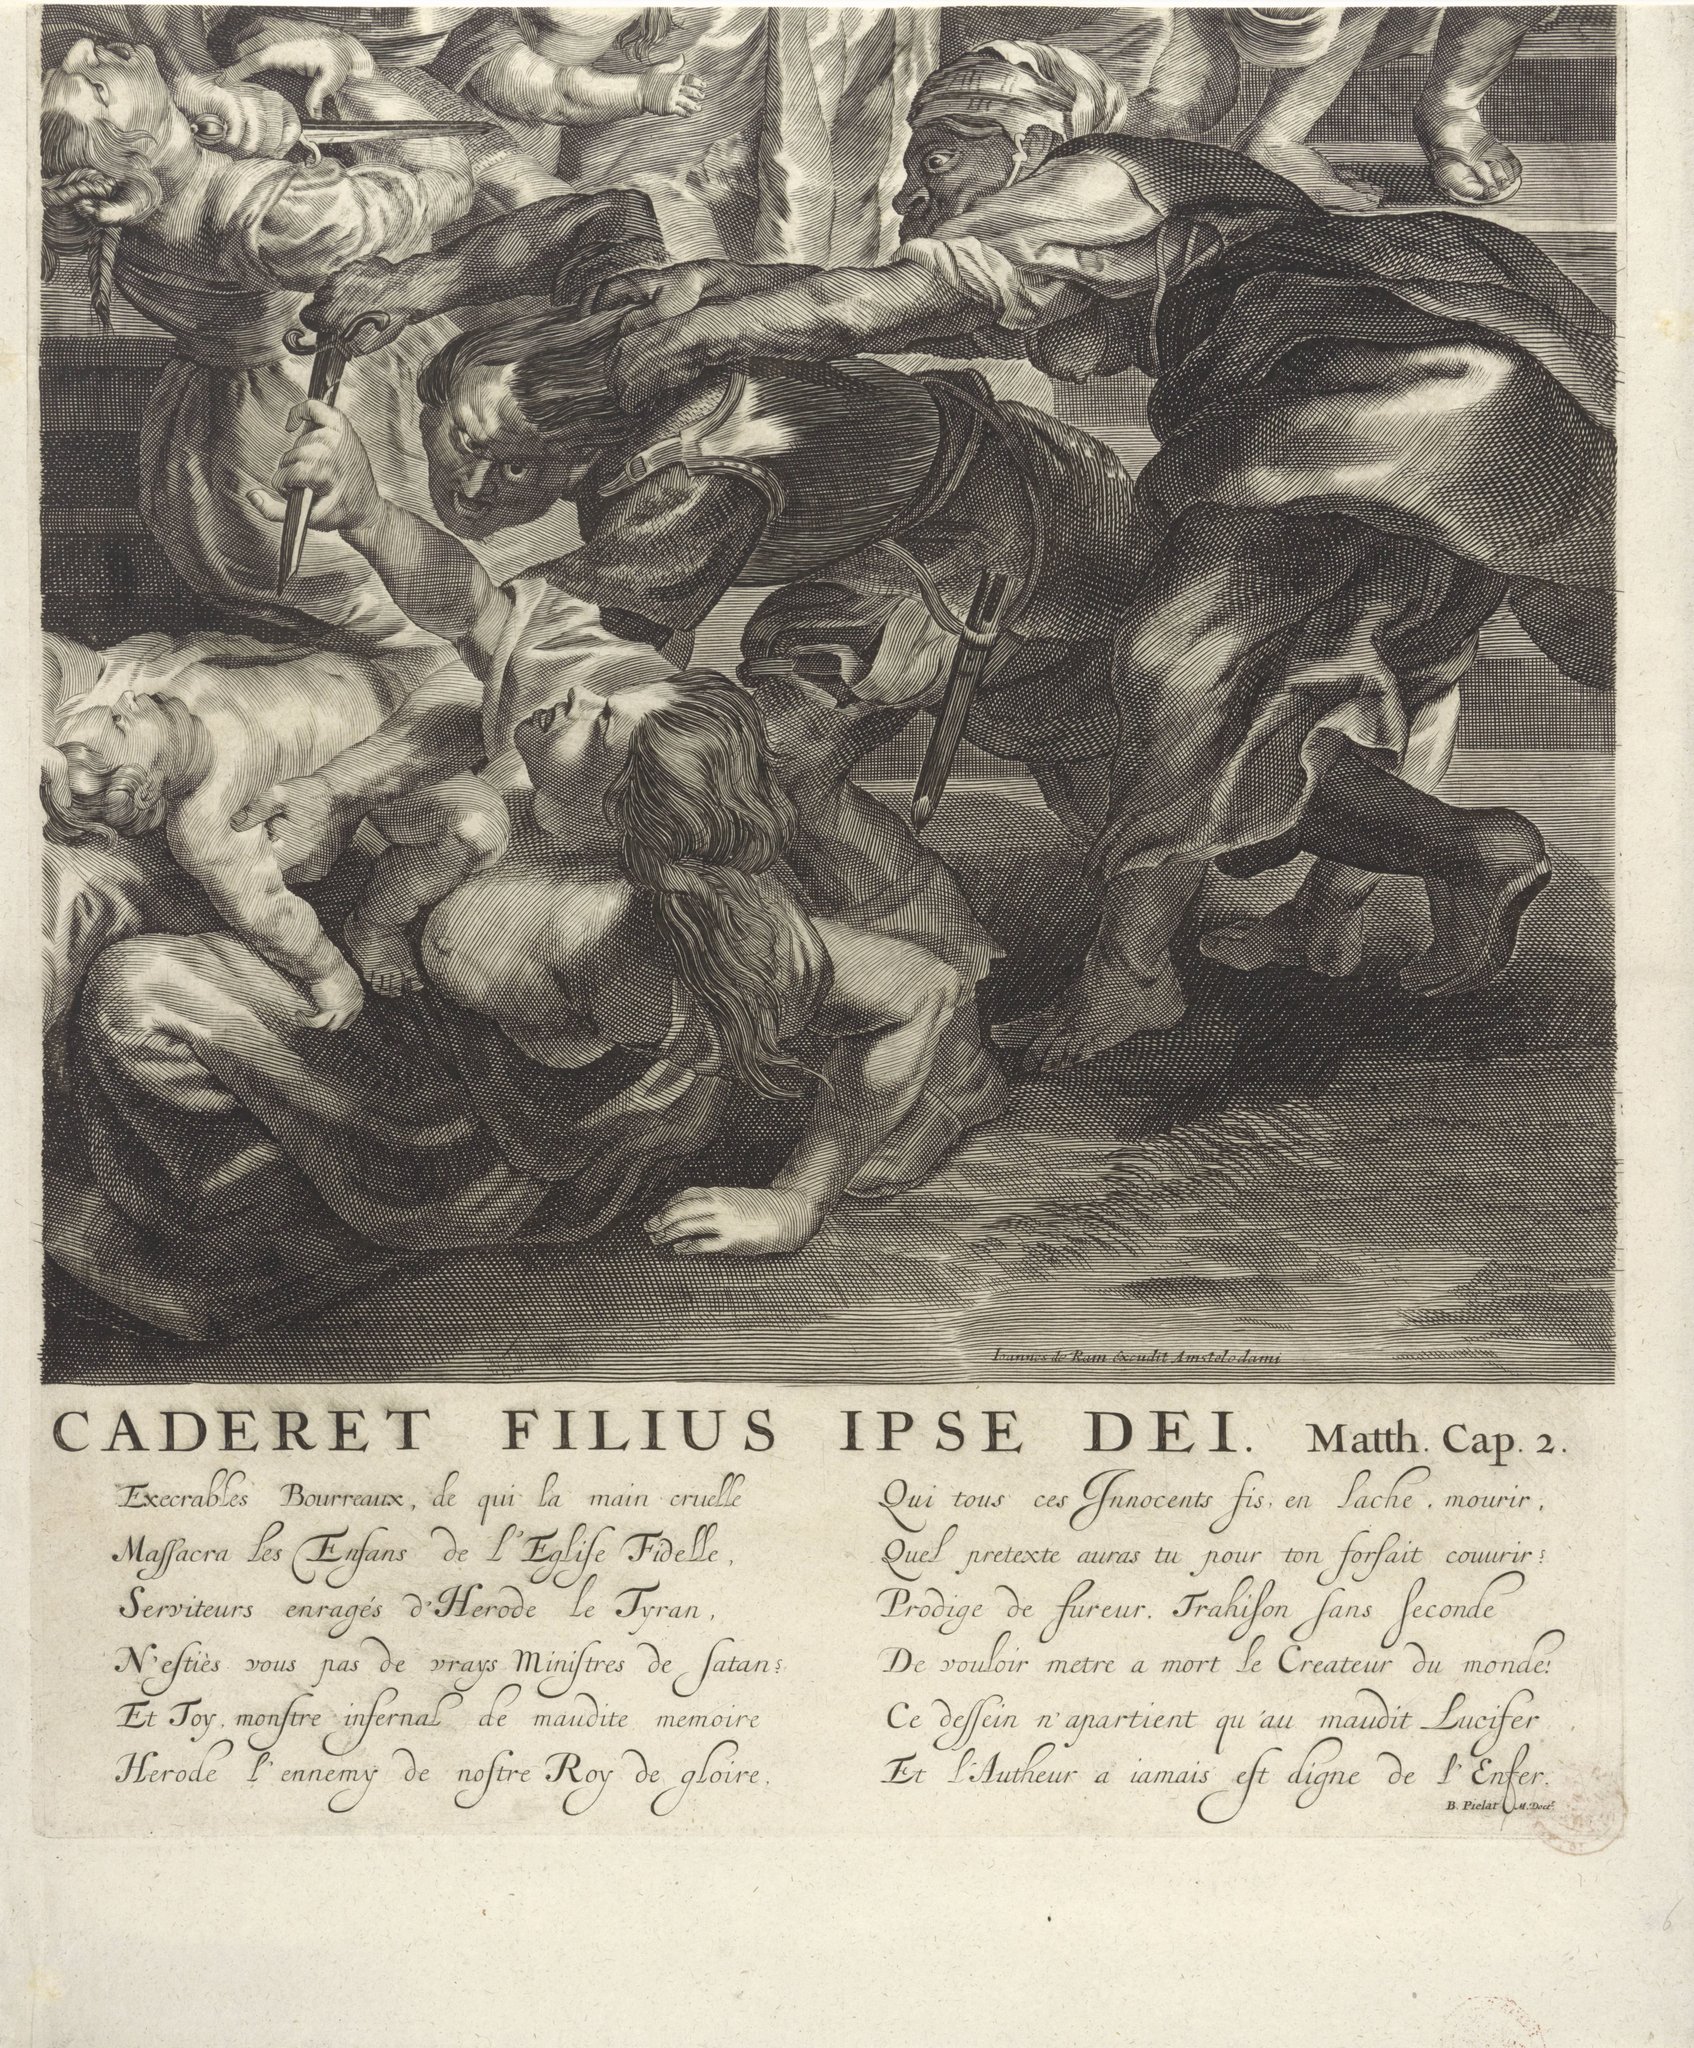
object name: print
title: Kindermoord te Betlehem, rechtsonder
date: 1668-1693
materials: paper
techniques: engraving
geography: antwerp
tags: the massacre of the innocents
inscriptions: collector's mark: Lugt 240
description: Fragment van de kindermoord te Betlehem. Wanhopige moeders proberen hun kinderen te beschermen tegen de soldaten van Herodes. In de marge een twaalfregelig onderschrift, in twee kolommen, in het Frans.